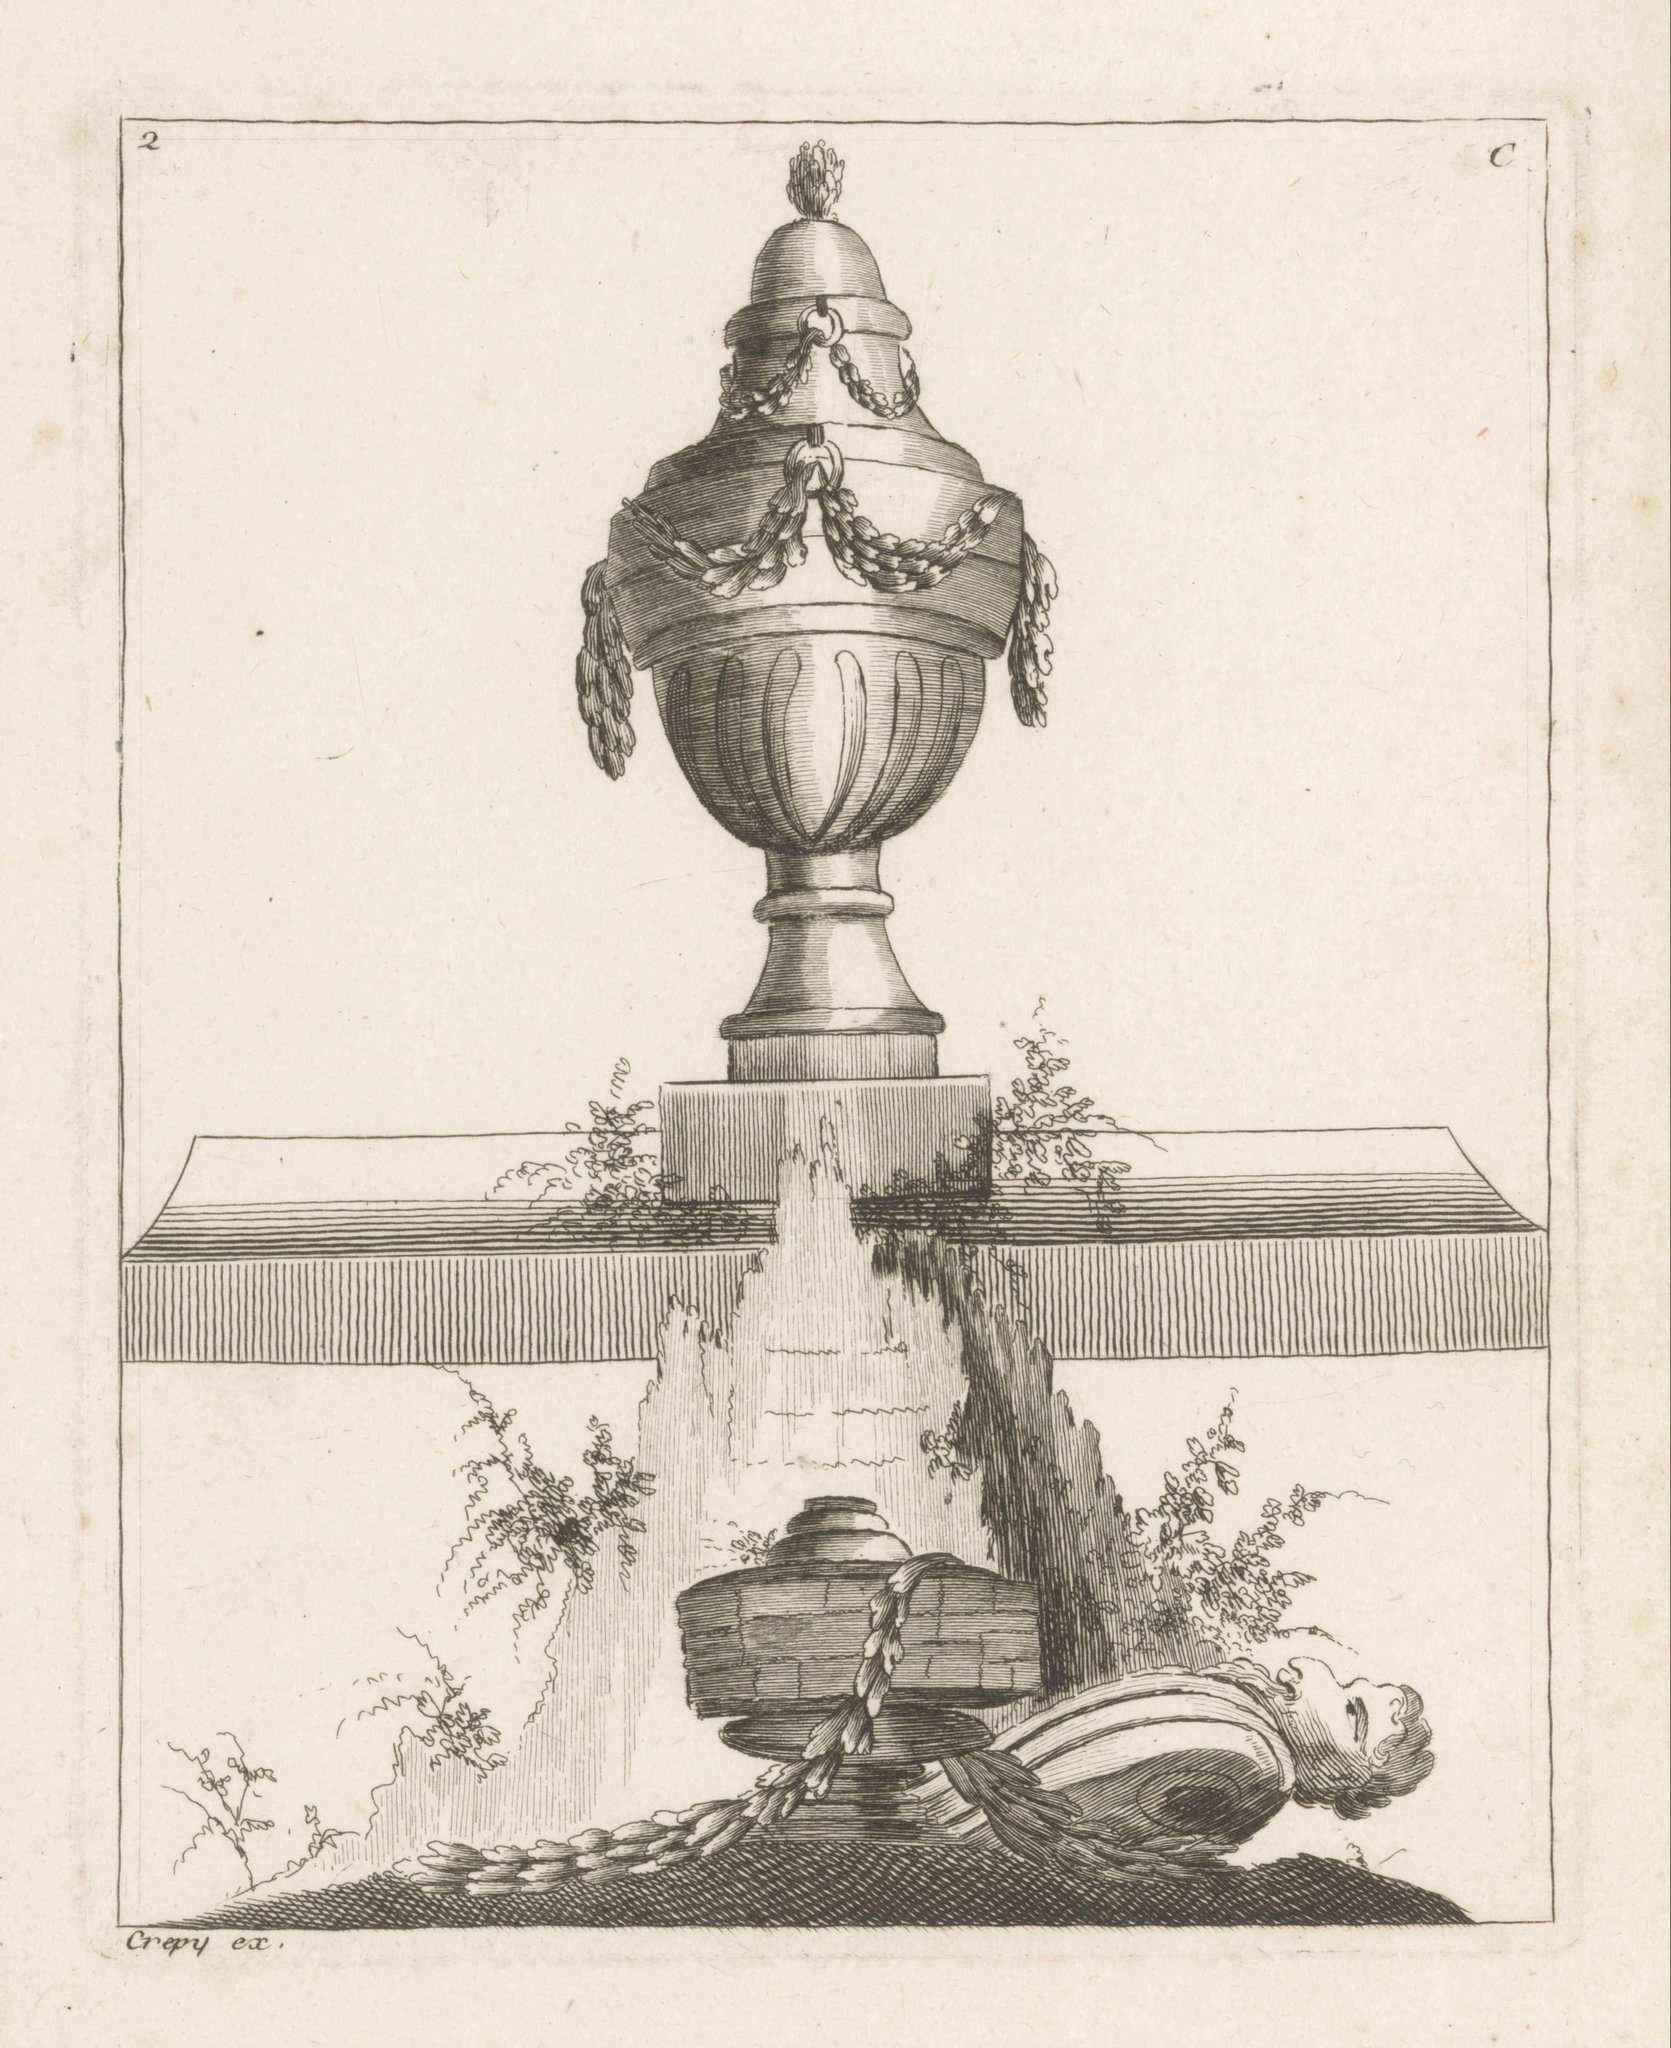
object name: print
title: Vaas met guirlandes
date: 1770-1780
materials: paper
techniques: etching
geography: paris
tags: vase ~ ornament, ornament ~ festoon, garland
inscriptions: collector's mark: Lugt 2228, collector's mark: Lugt 2760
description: Een vaas met guirlandes. Daaronder een vaas en een console met masker.